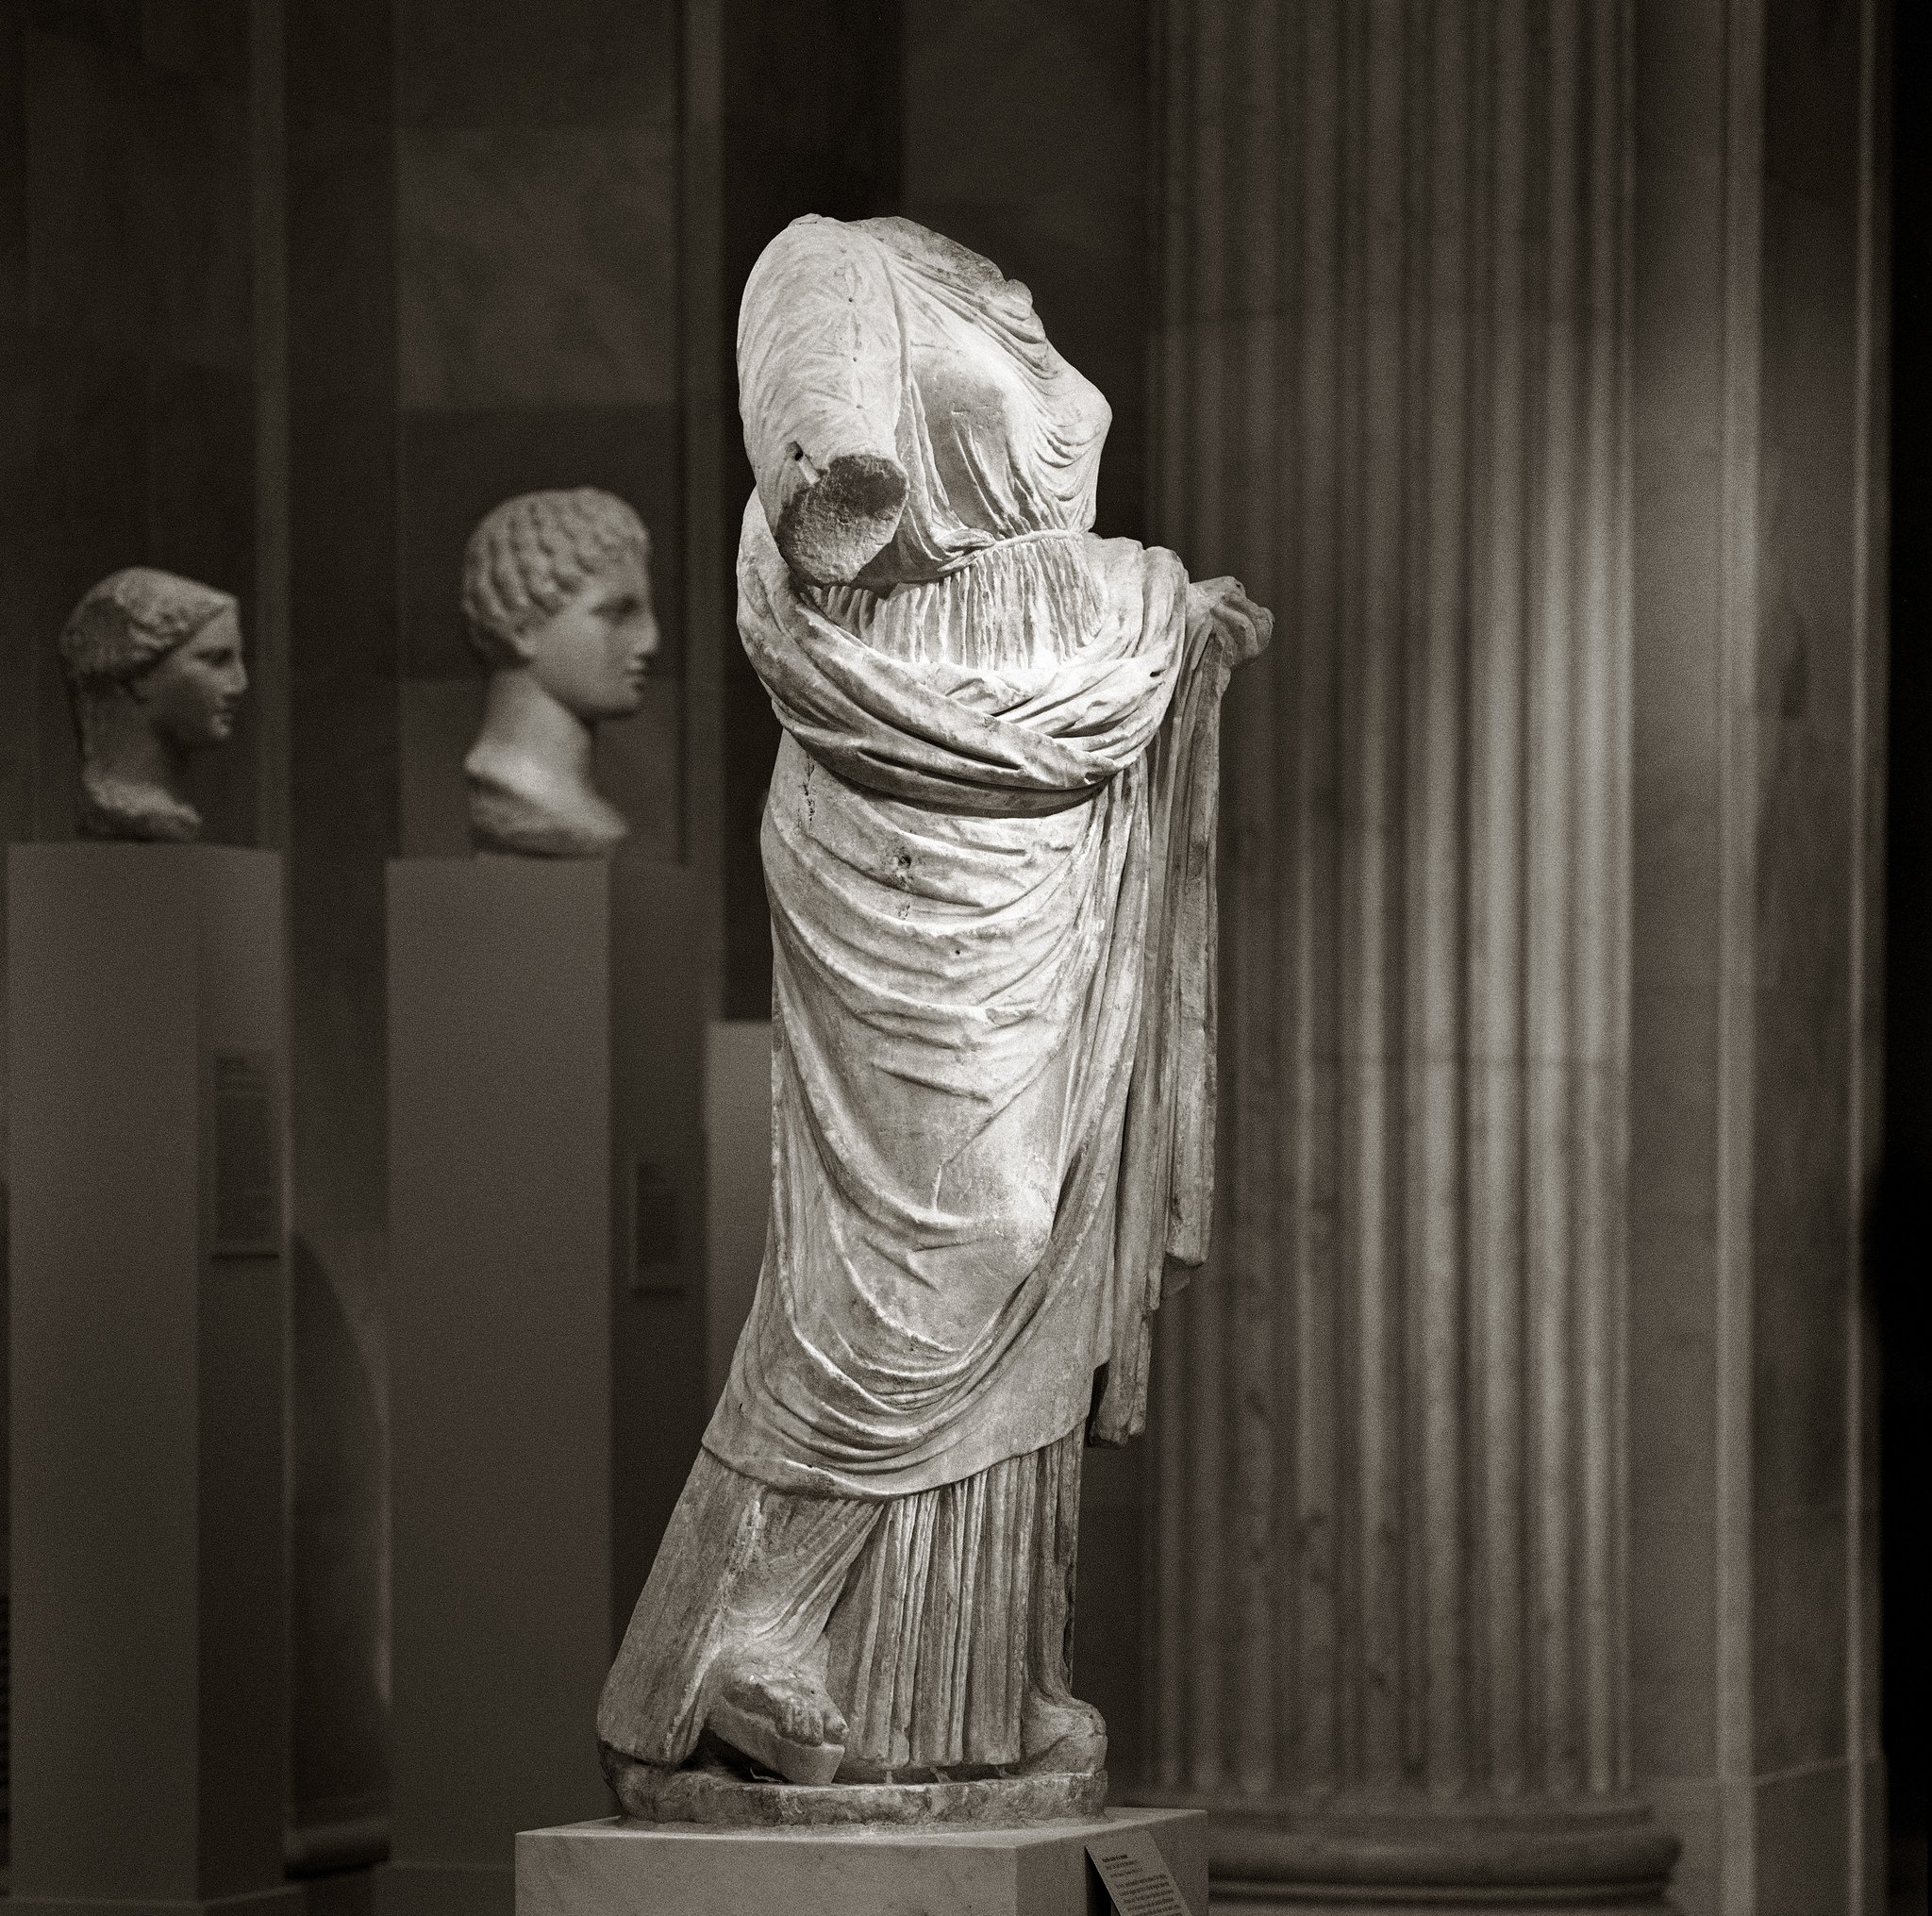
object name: statue of a woman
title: Marble statue of a woman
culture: greek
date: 350-301 BCE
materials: marble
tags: women